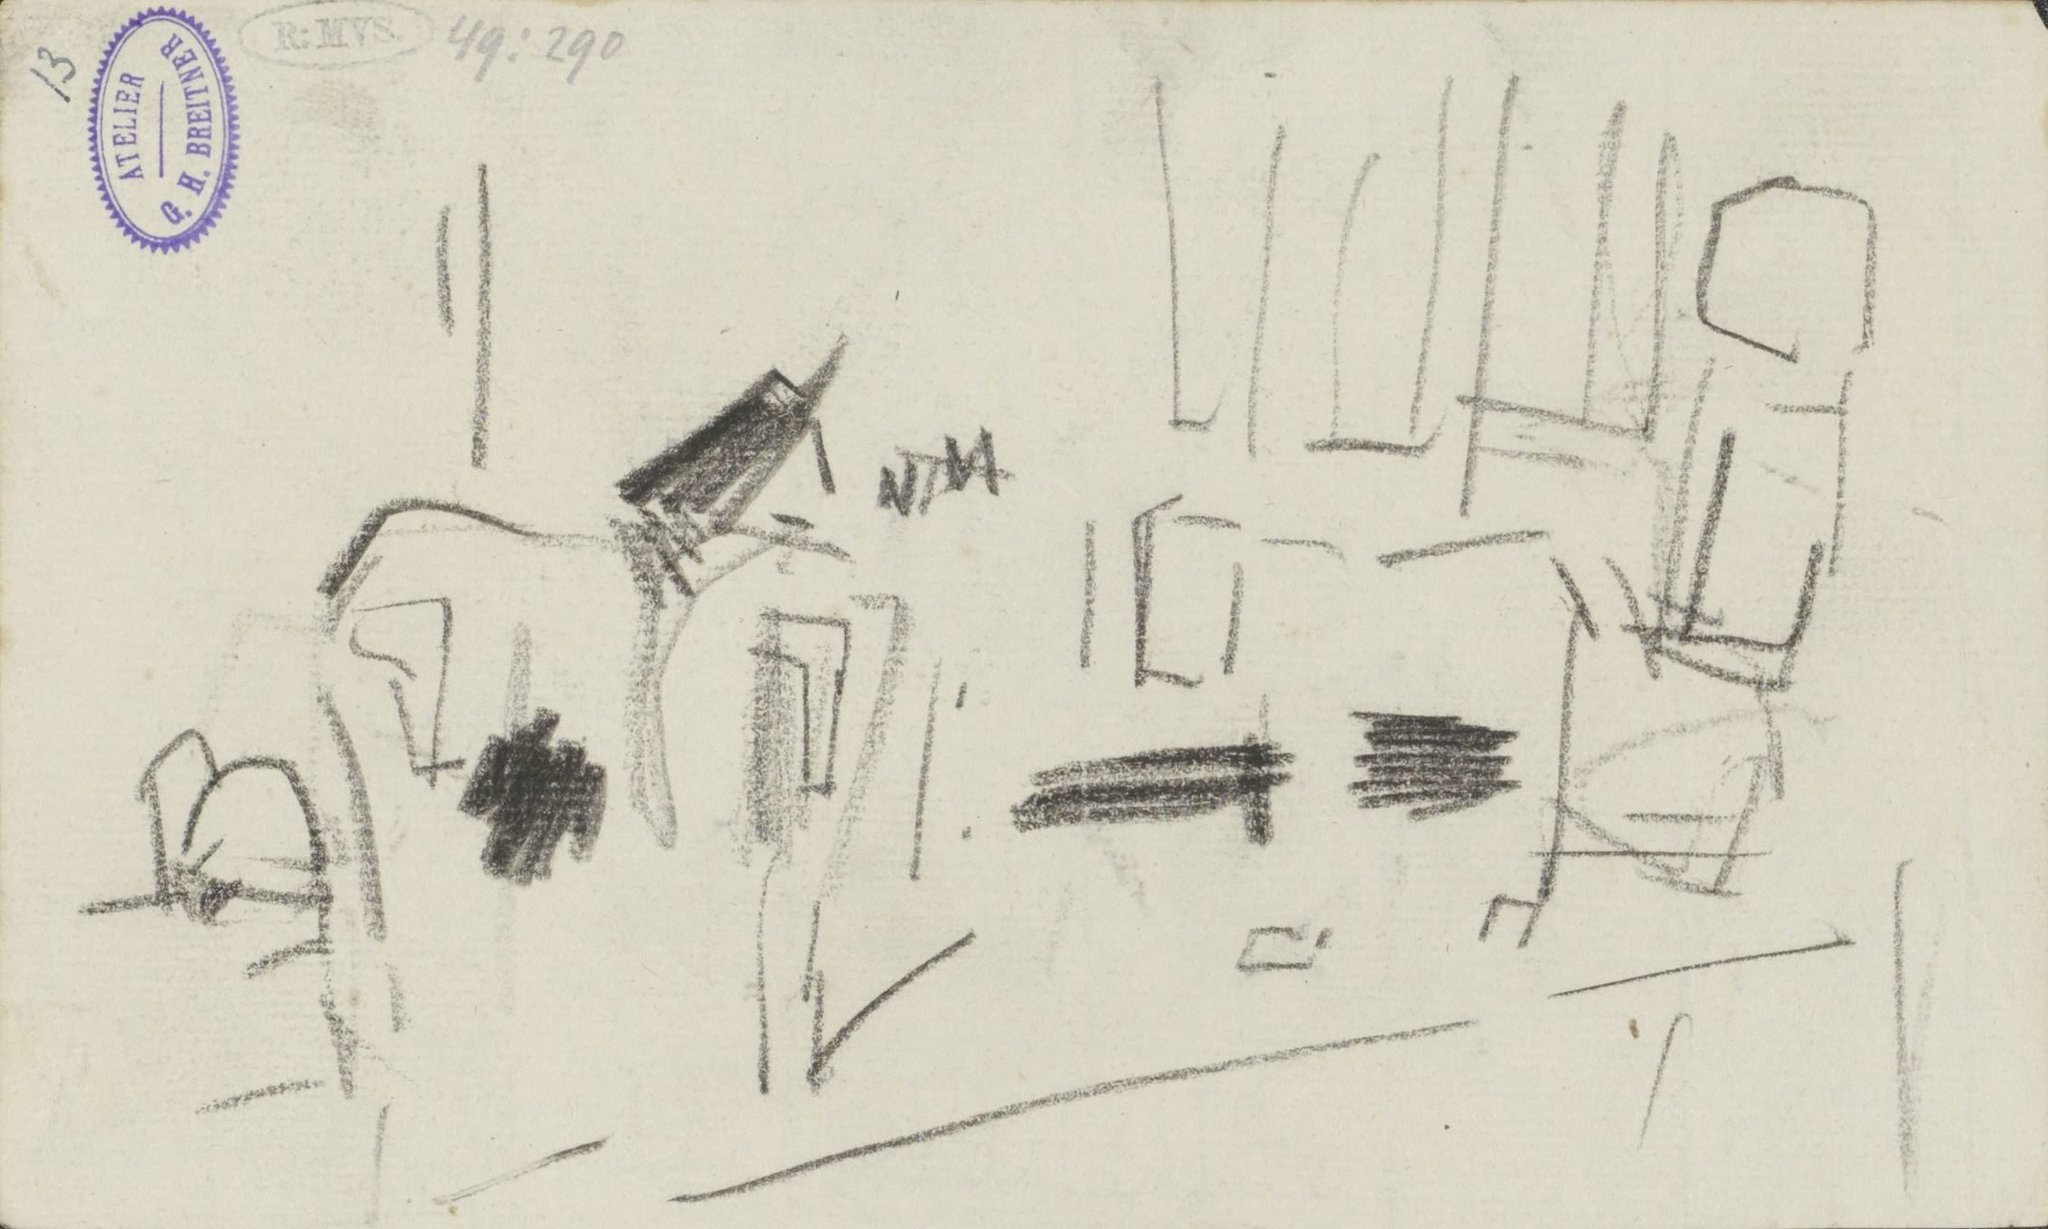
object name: drawing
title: Paarden op straat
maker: george hendrik breitner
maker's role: draughtsman, painter, print maker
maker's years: 1857-1923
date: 1873-1886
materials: chalk, paper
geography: loosduinen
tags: horse, street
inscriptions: collector's mark: Lugt 2228, workshop stamp: Lugt 291d